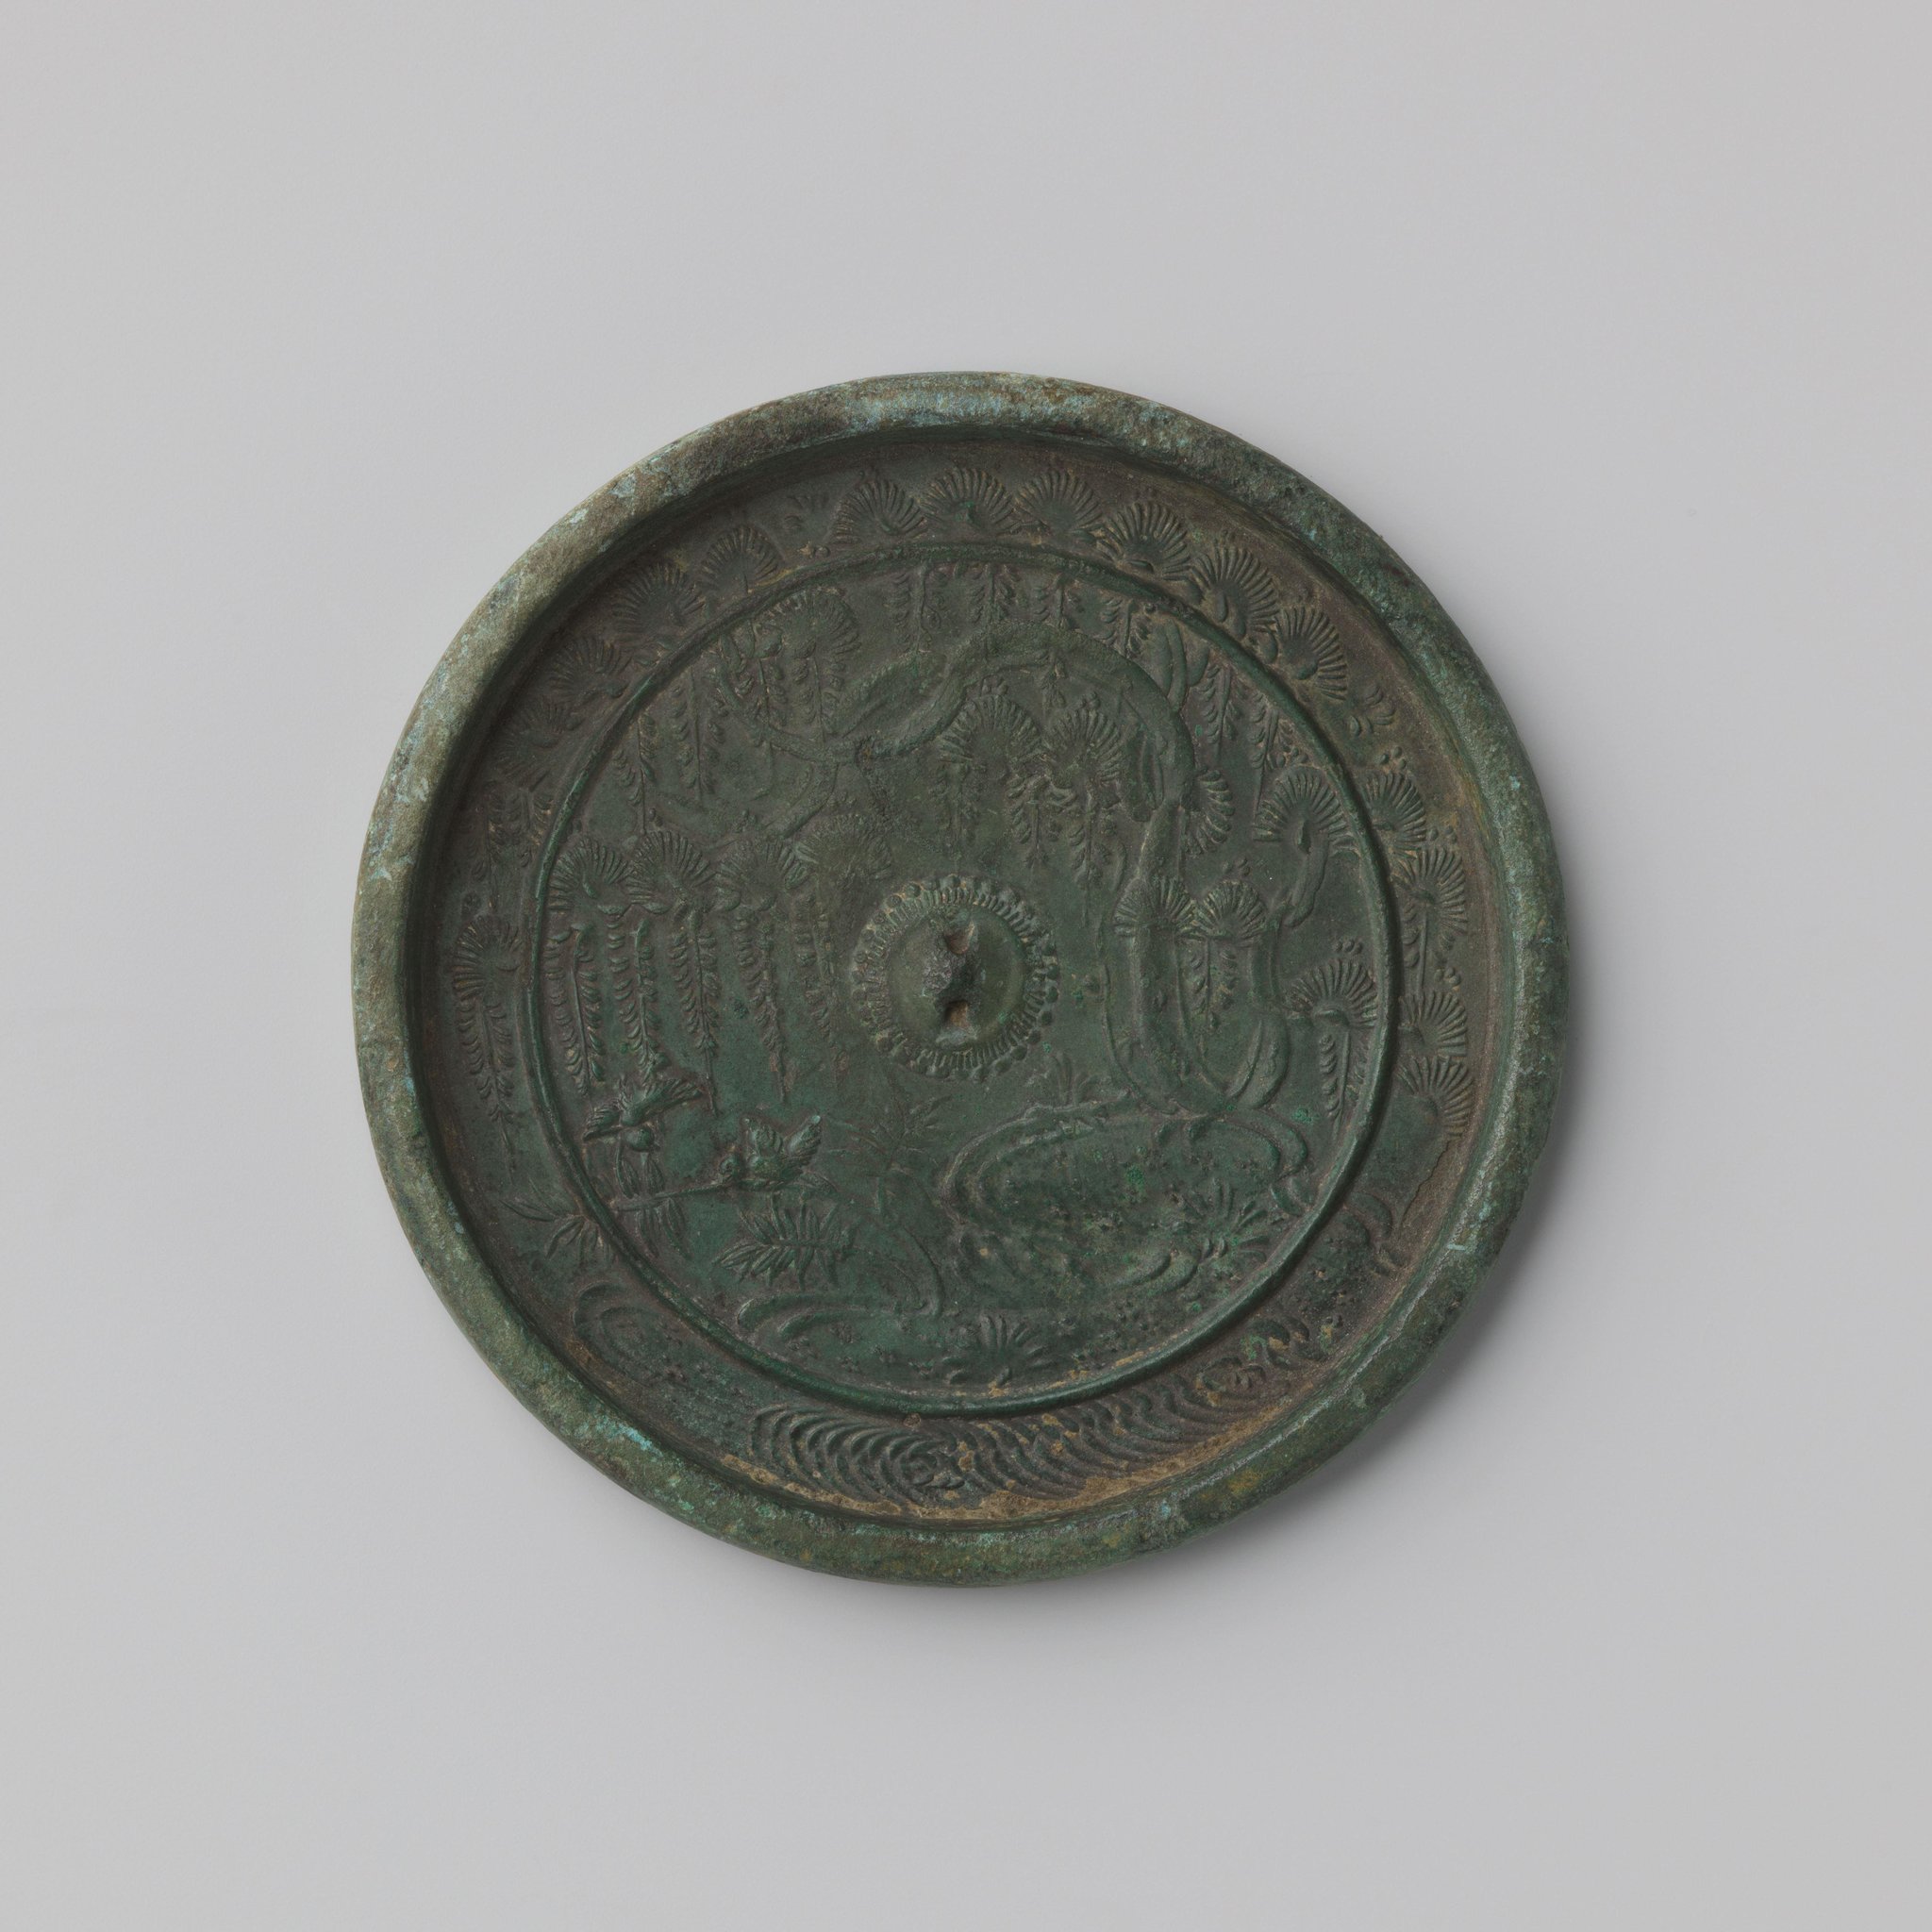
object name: mirror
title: Spiegel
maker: Anonymous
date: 1185-1333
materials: bronze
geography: japan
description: Spiegel waarvan het middenveld versierd is met wisteria, vogels, waterplanten en een beek.